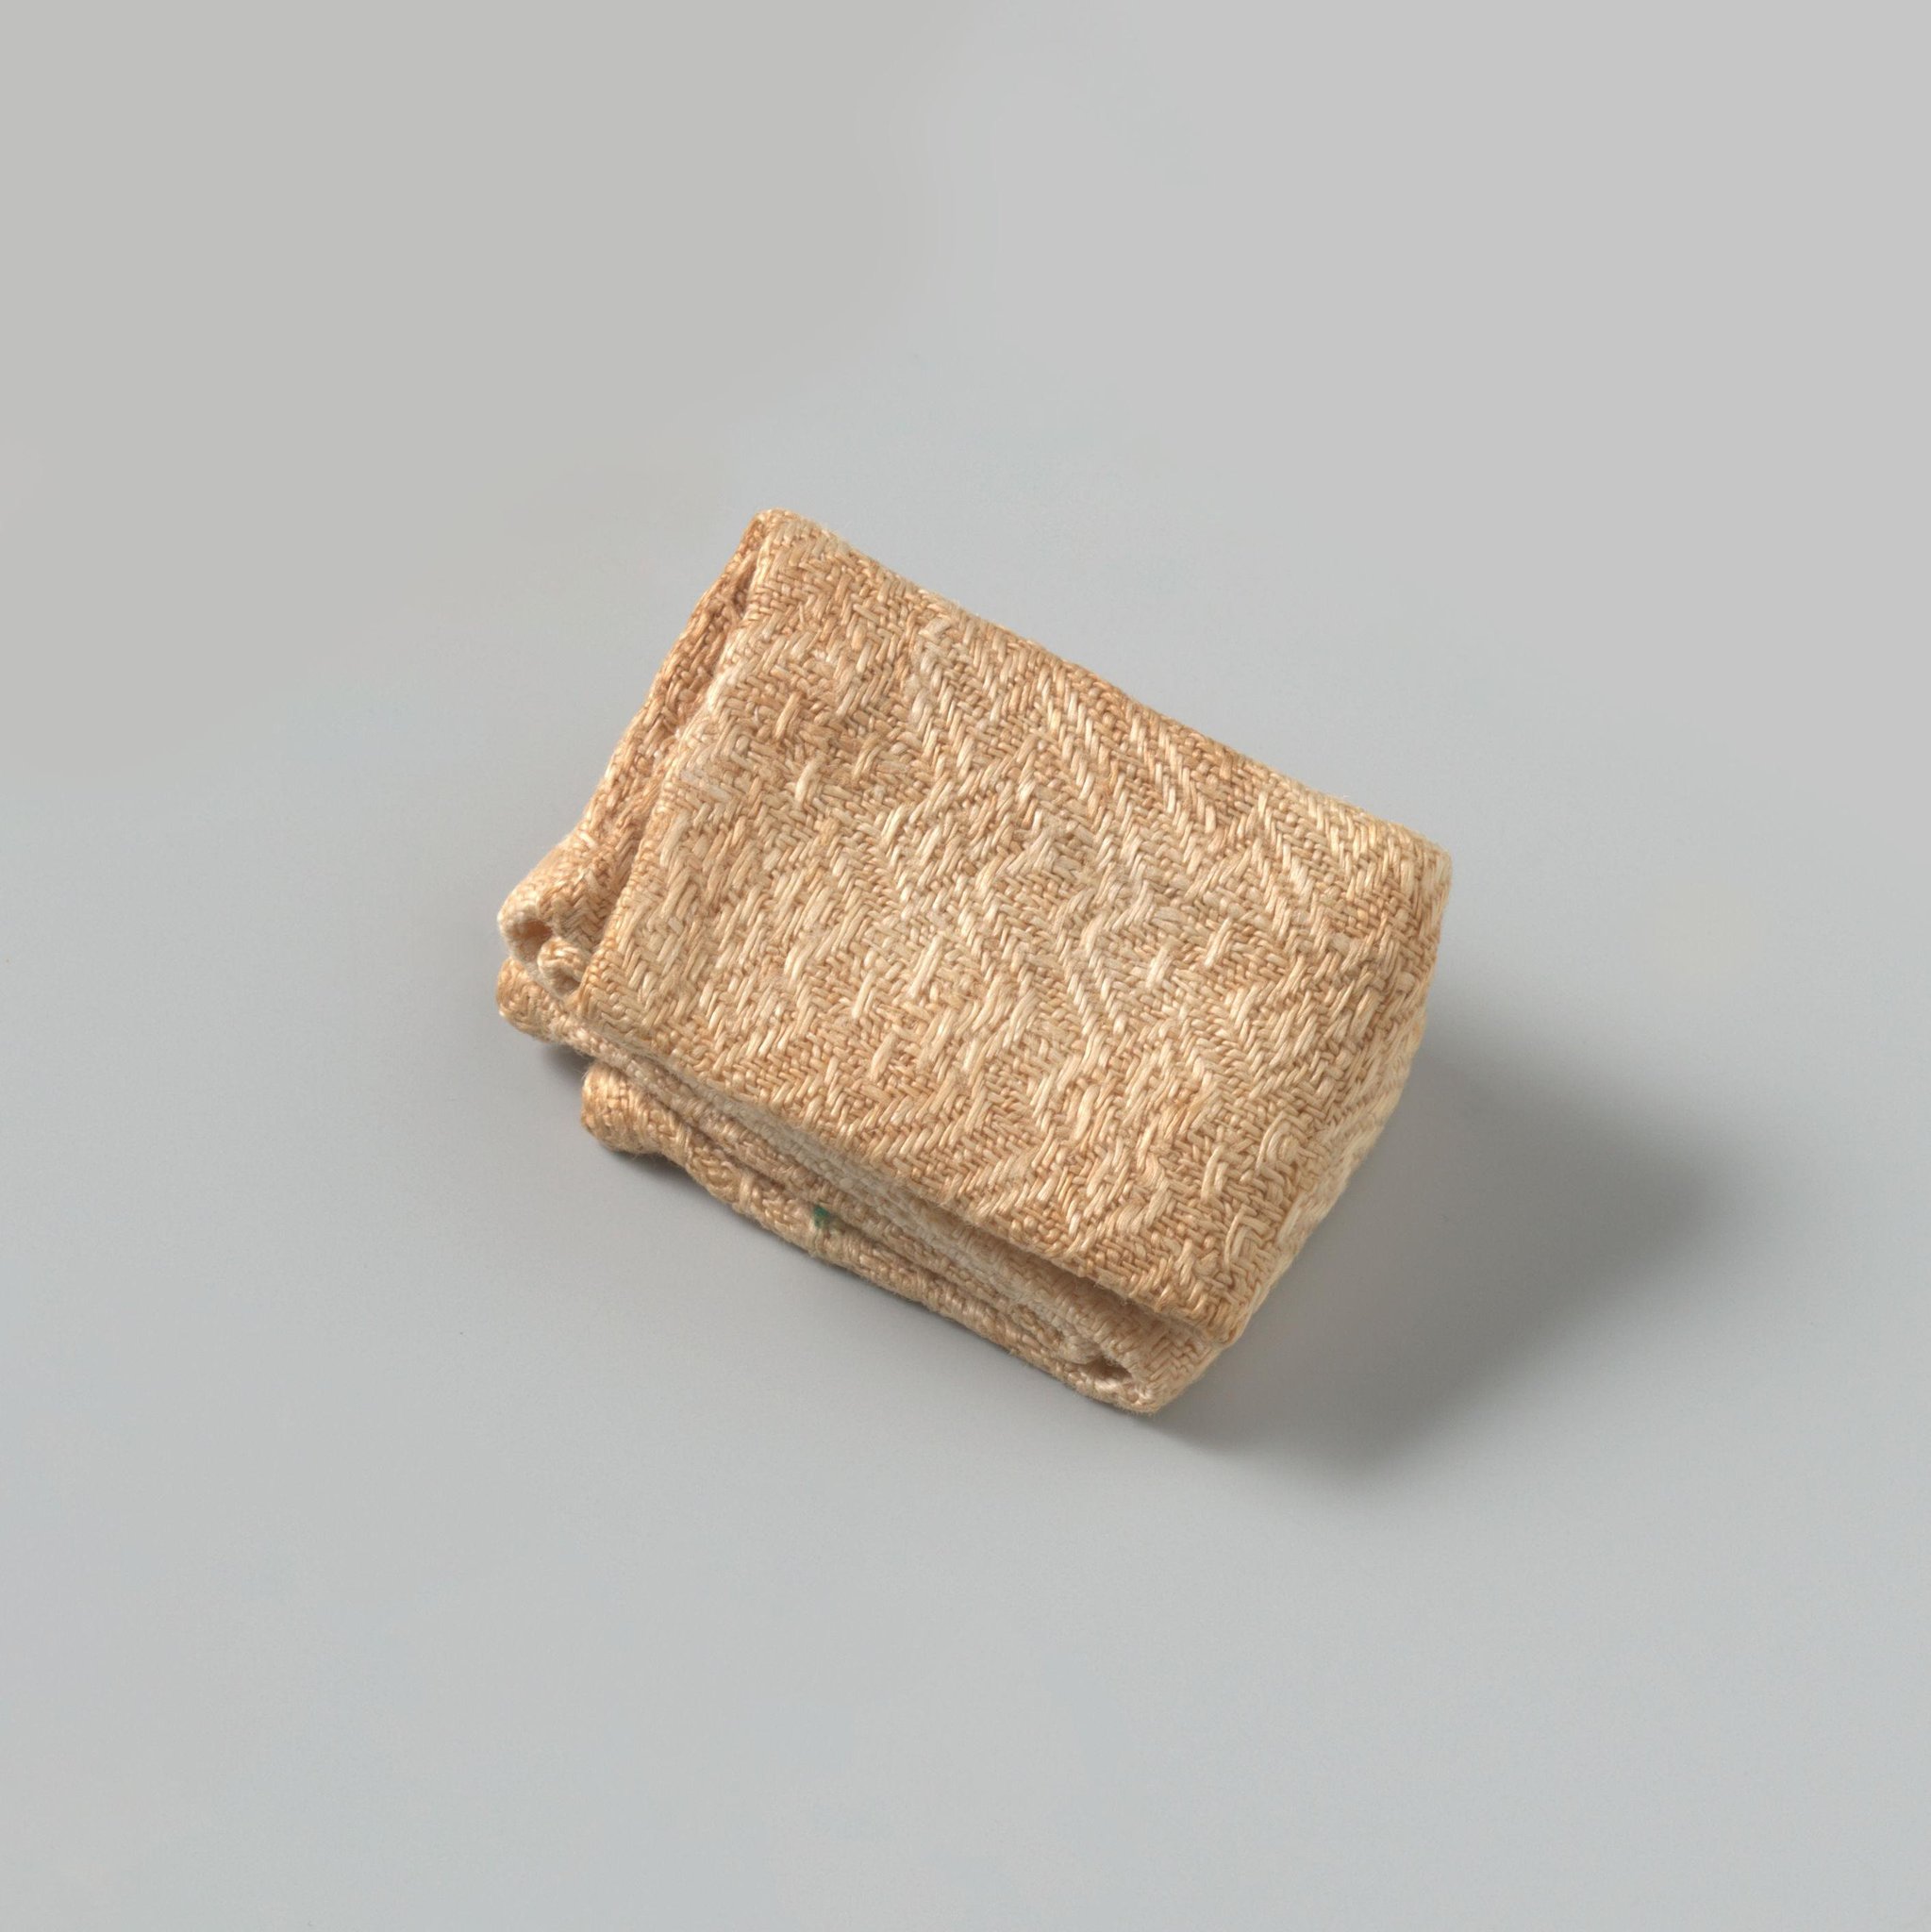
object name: napkin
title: Servet, damastweefsel met pellenpatroon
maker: Anonymous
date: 1600-1699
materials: linen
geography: netherlands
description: Servet, damastweefsel met een pellenpatroon, geknipt uit grotere stukken linnen en aan alle kanten omgezoomd met een fijne zoom.